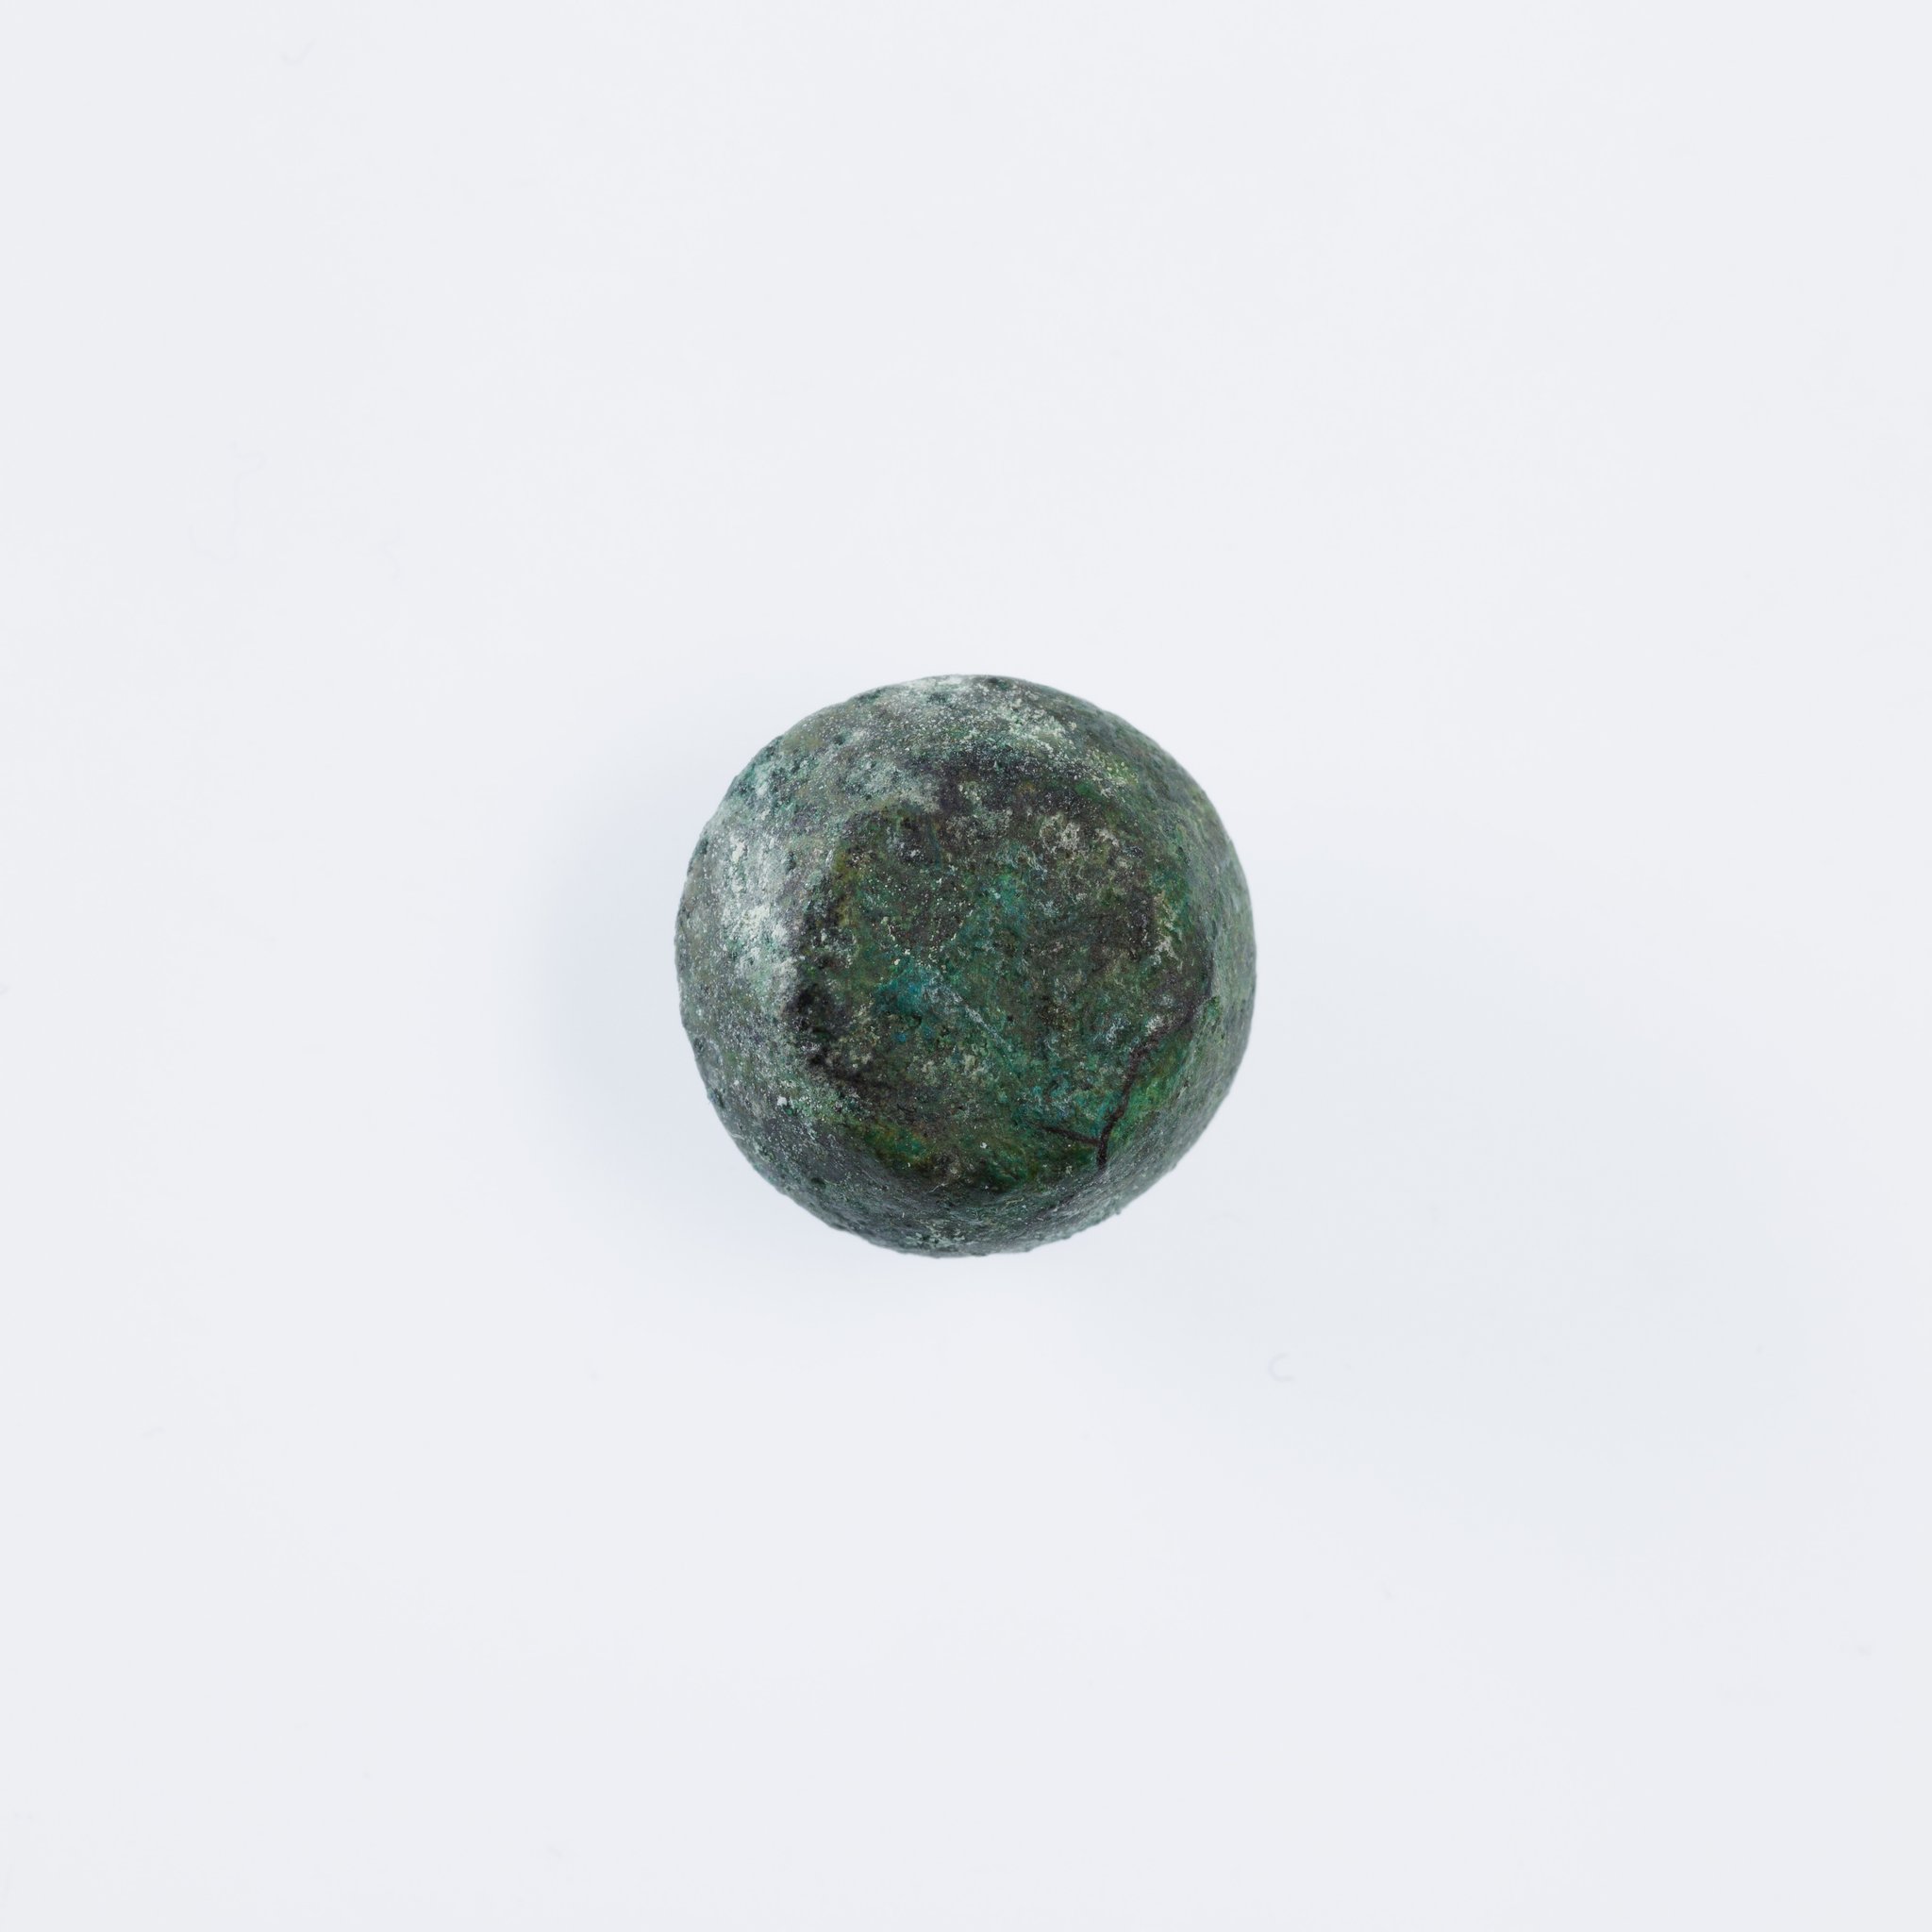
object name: weight, qedet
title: 1/2 Qedet weight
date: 664-630 BCE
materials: bronze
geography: egypt